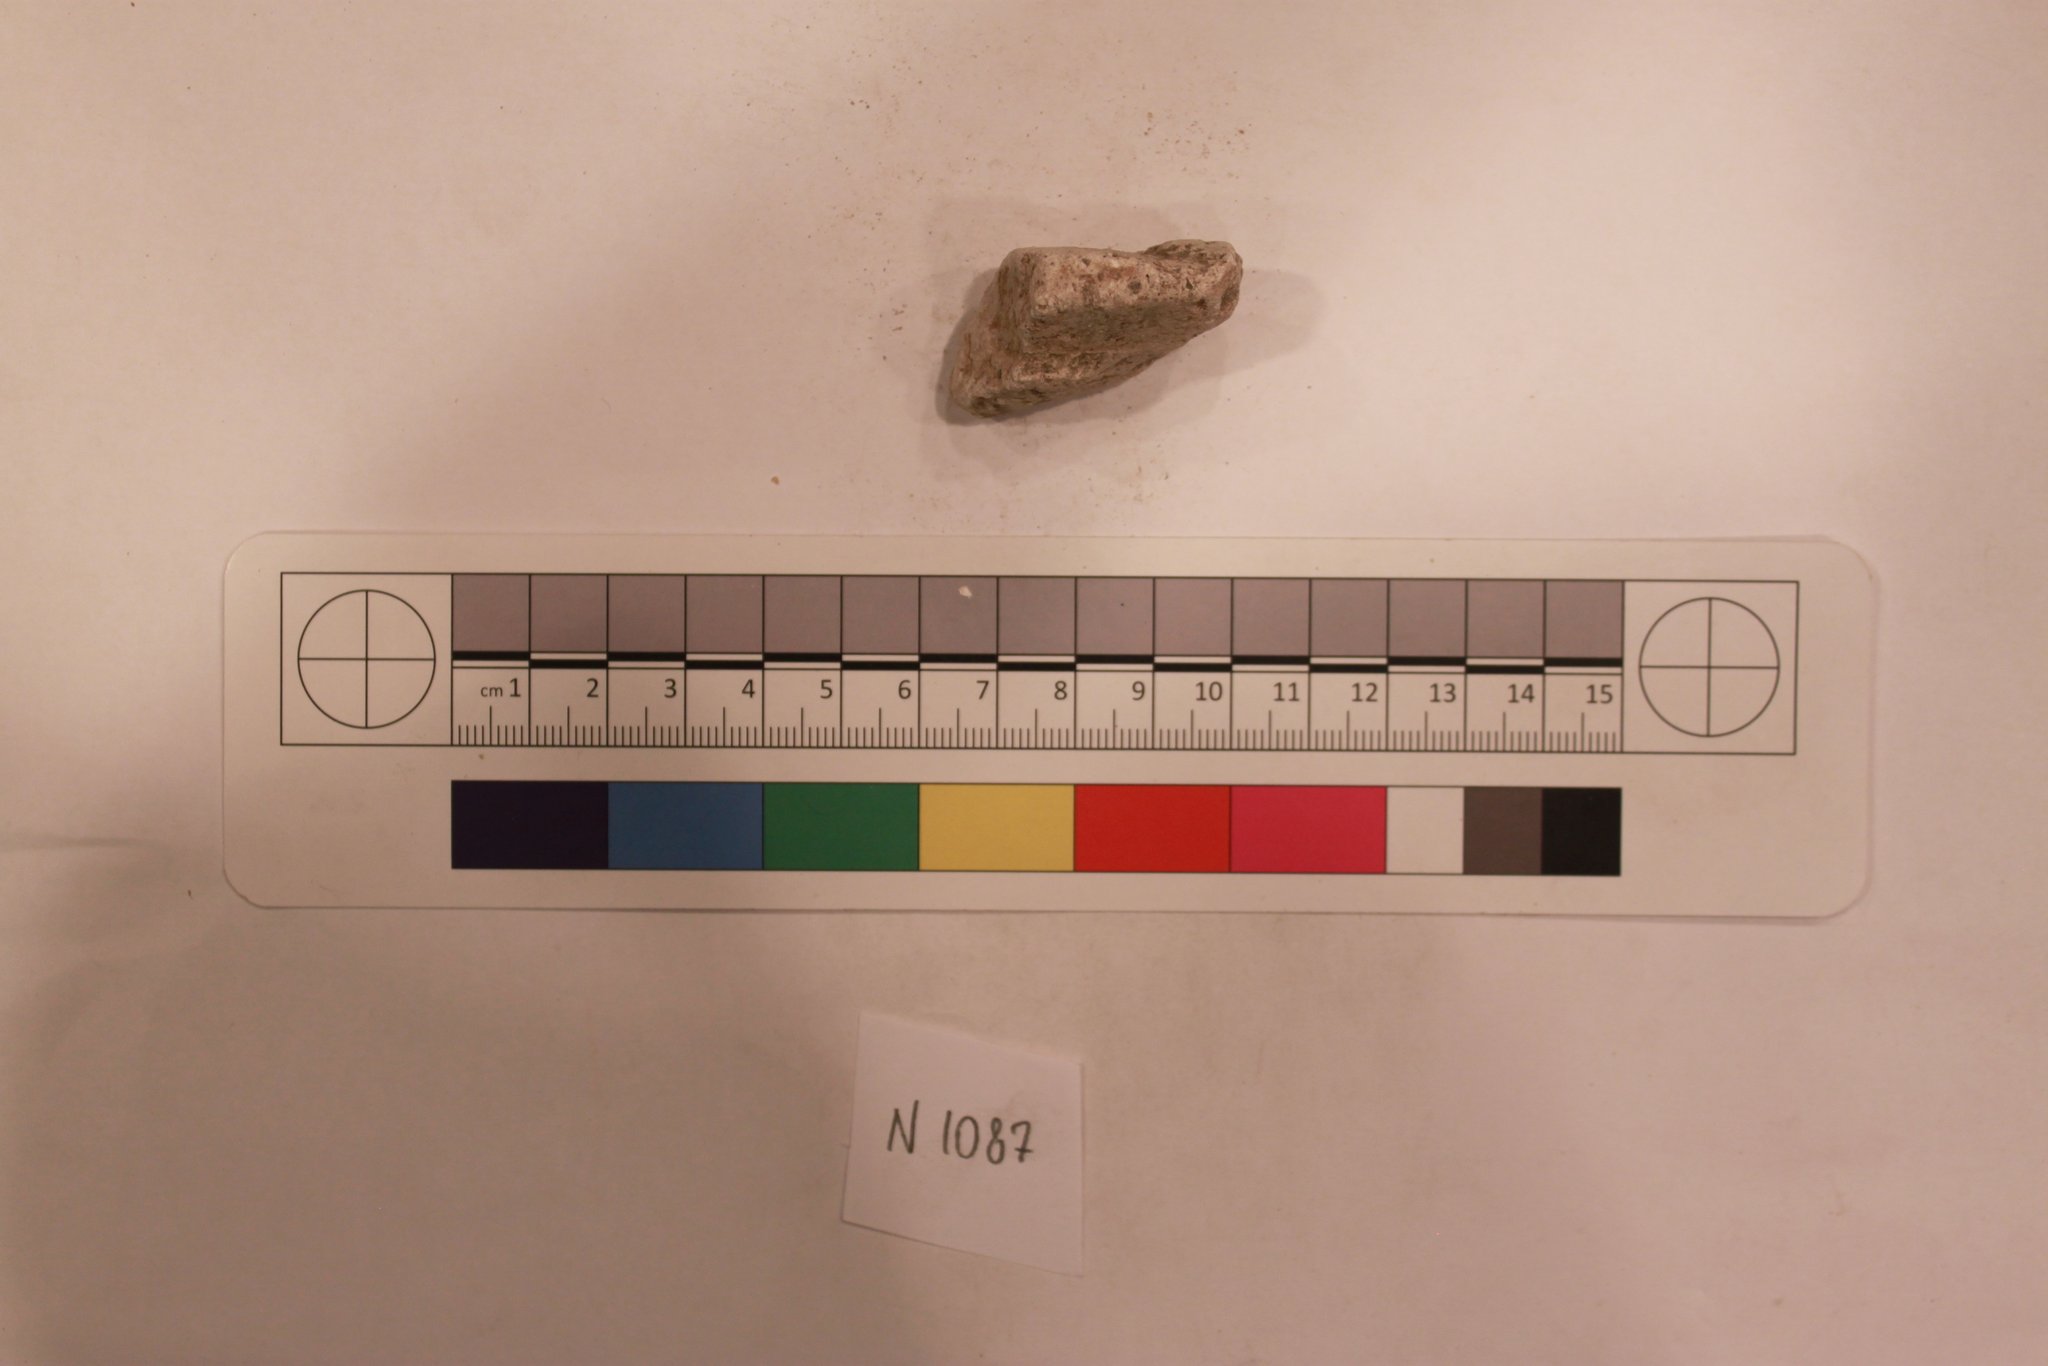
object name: fragment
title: Stucco Fragment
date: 701-1200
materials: plaster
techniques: carving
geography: iran